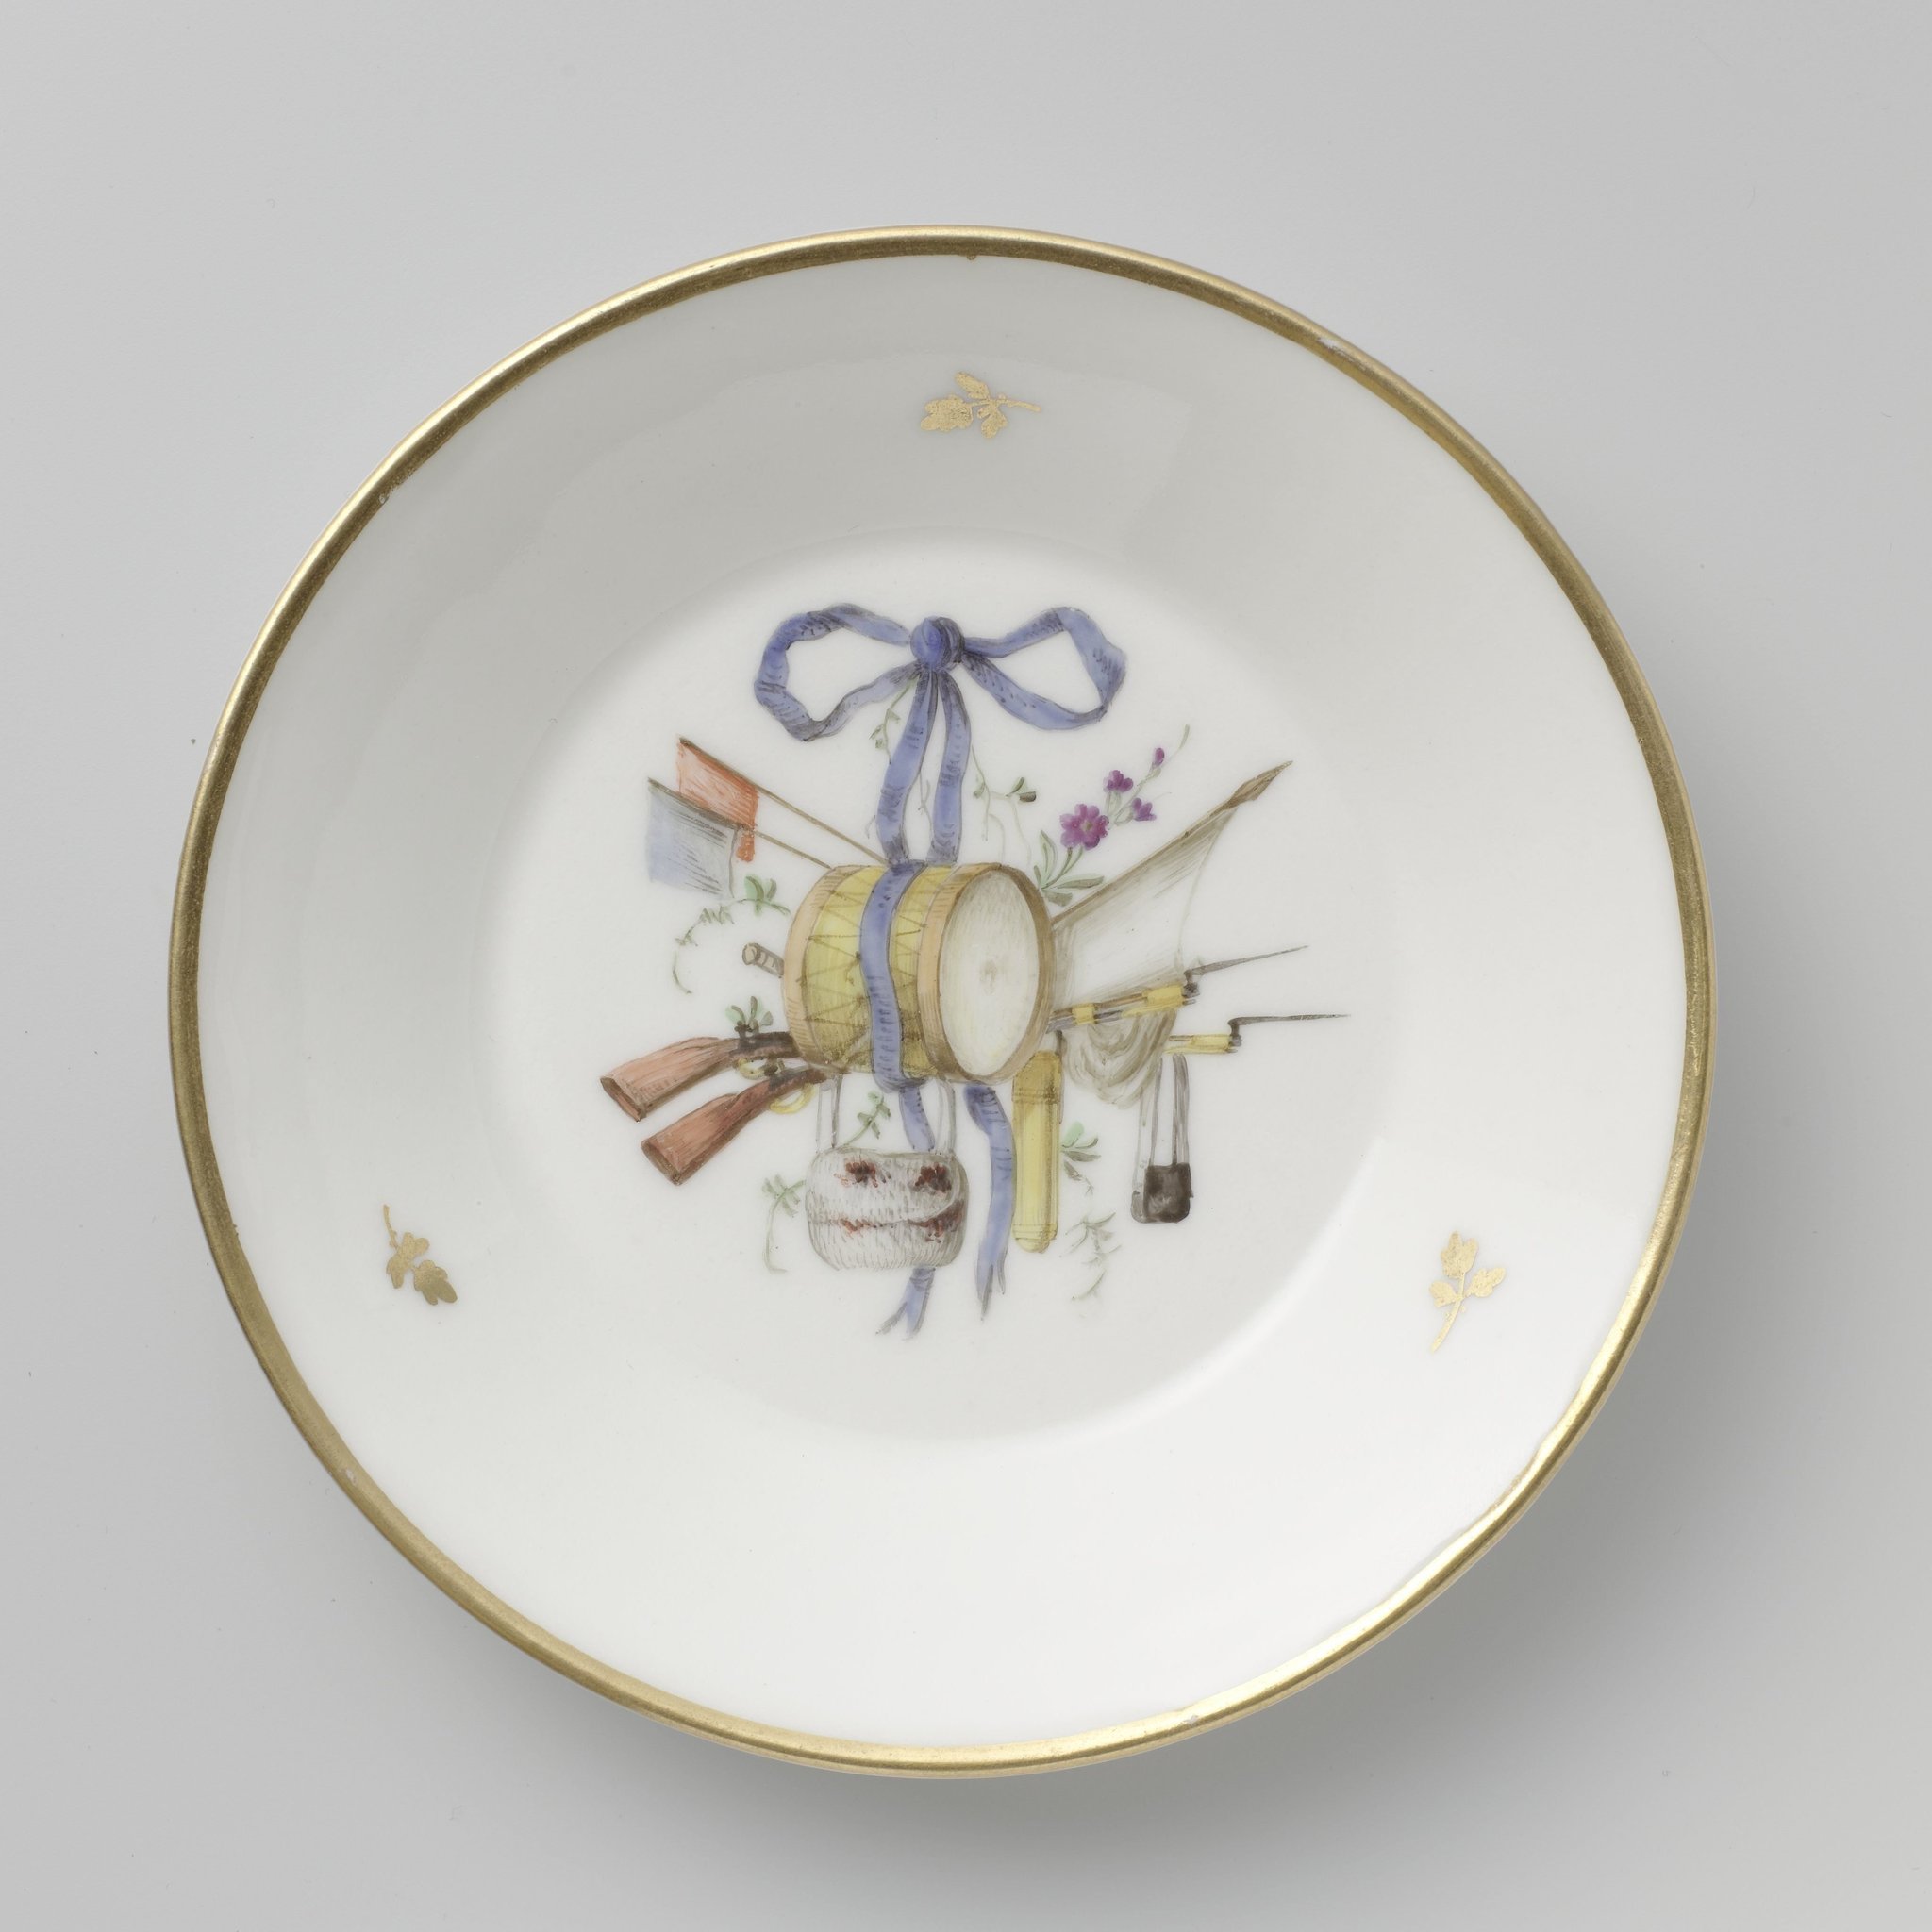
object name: platter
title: Teacup and saucer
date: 1809-1814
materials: porcelain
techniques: painted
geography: nieuwer-amstel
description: Koninklijke Porseleinfabriek Dommer & Co. Nieuwer-Amstel, c. 1809–1814 hard-paste porcelain